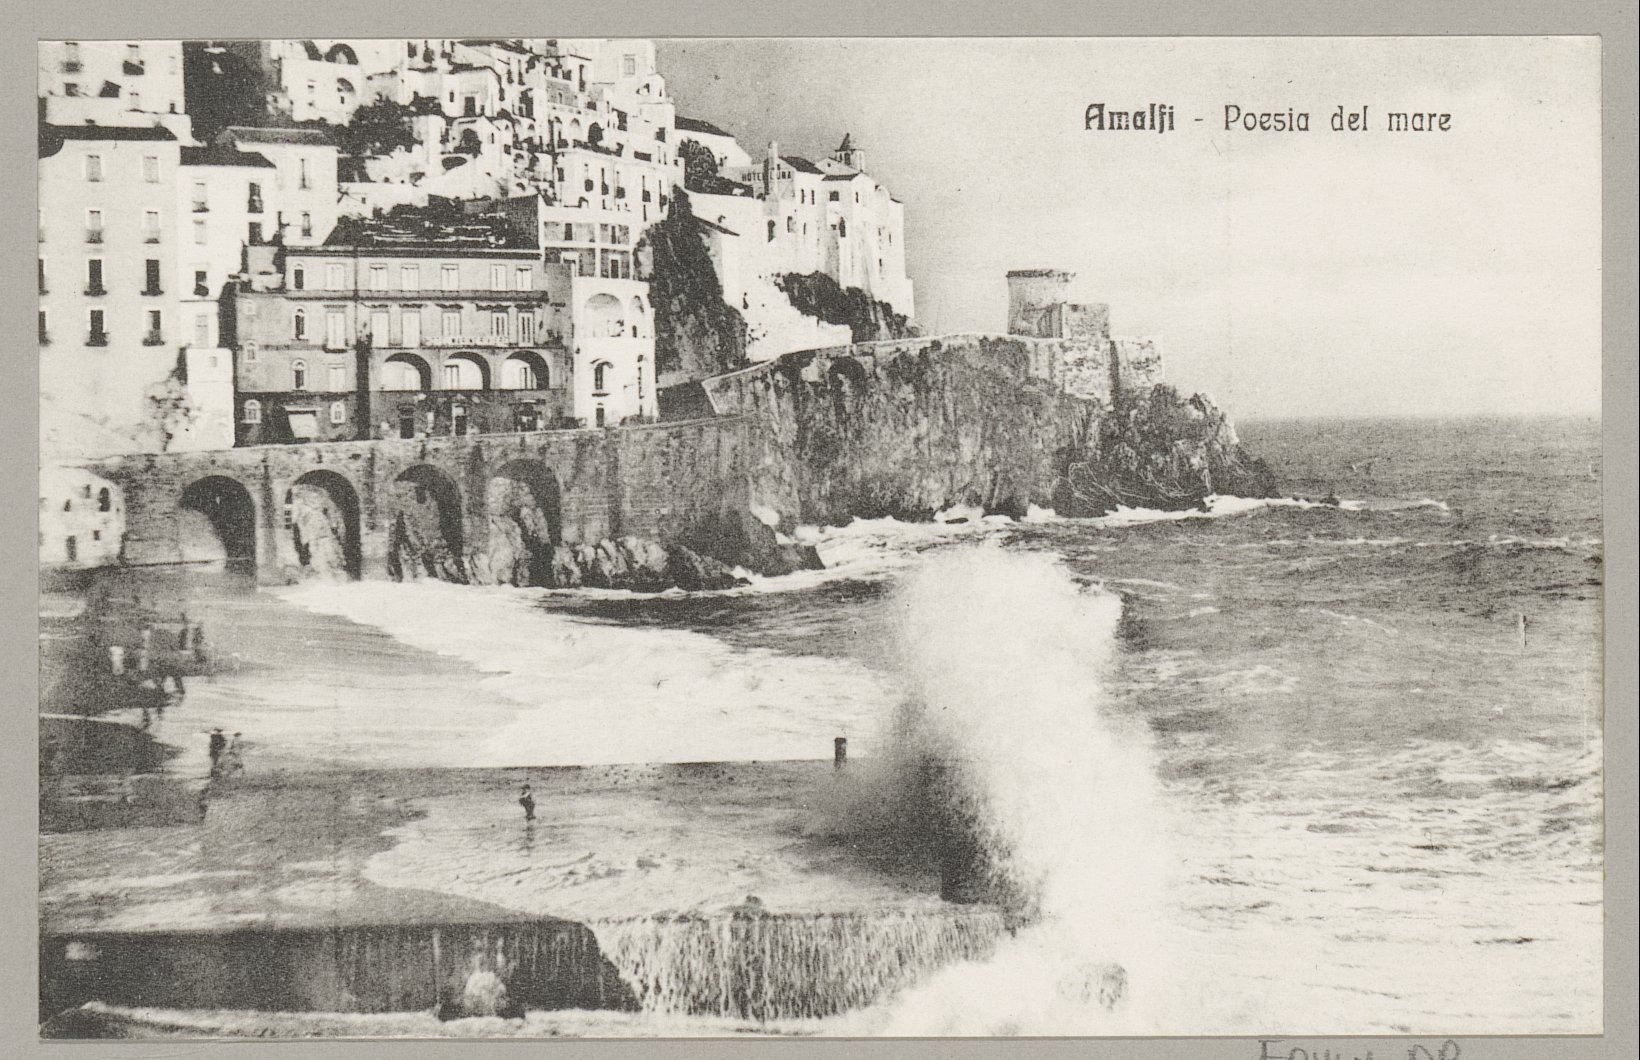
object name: photomechanical print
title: Gezicht op het strand bij Amalfi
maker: Anonymous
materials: paper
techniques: photograph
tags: prospect of village, silhouette of village, surf, breakers, beach, amalfi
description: Onderdeel van Fotoalbum van een reis door Zuid-Europa en het Midden-Oosten.